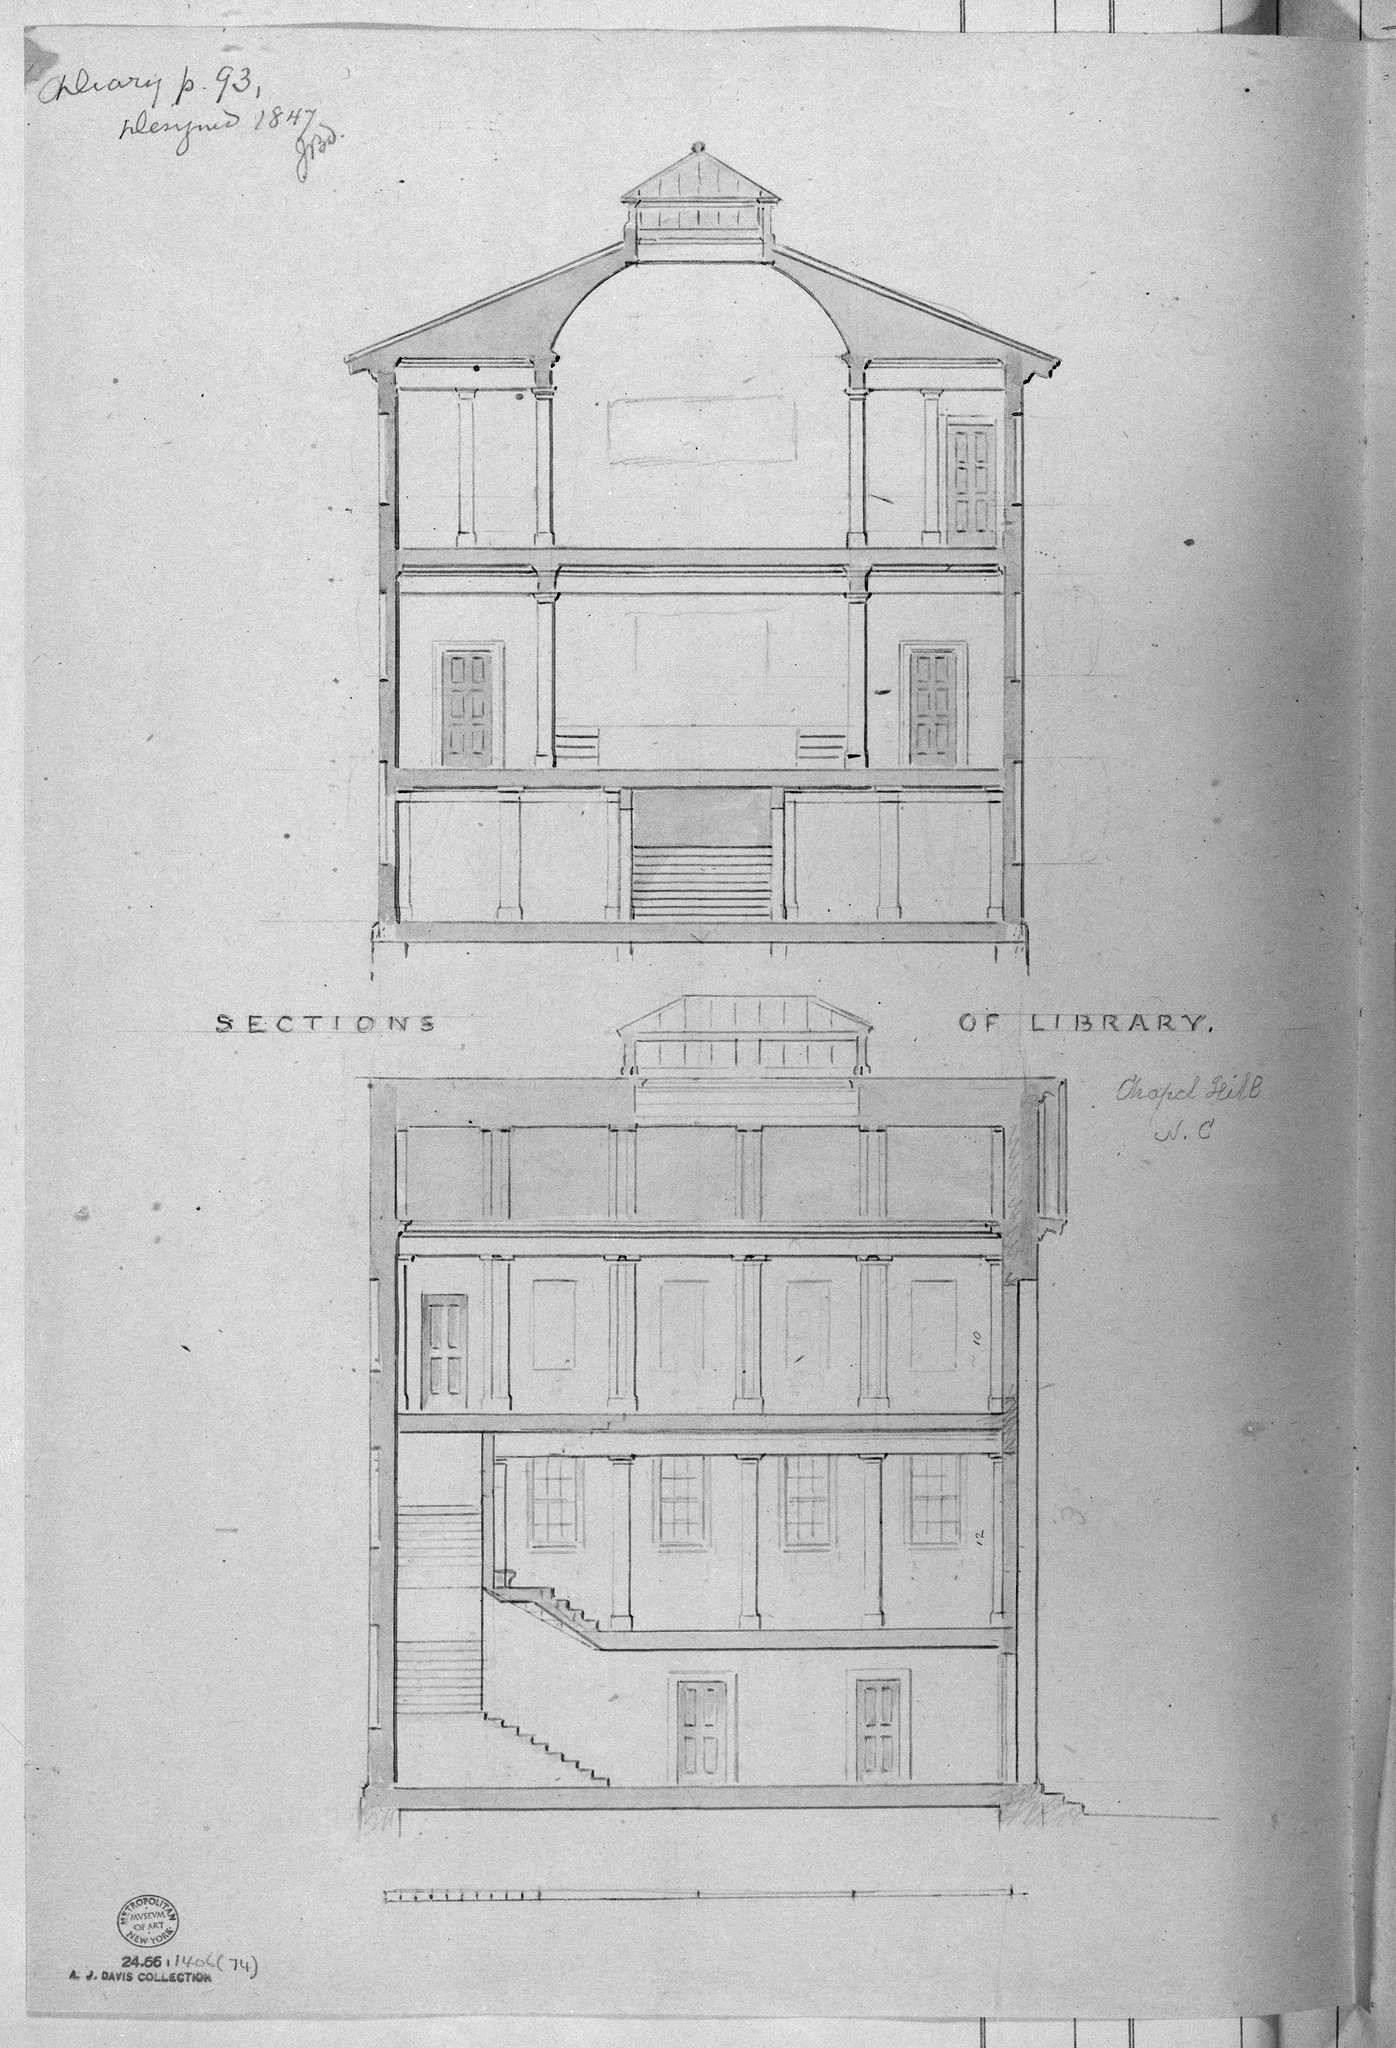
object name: album print ornament architecture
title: A. J. Davis, Scrapbook VII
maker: alexander jackson davis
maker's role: artist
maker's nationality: american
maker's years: 1803-1892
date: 1801-1900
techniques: bookbinding, drawing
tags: architecture,houses